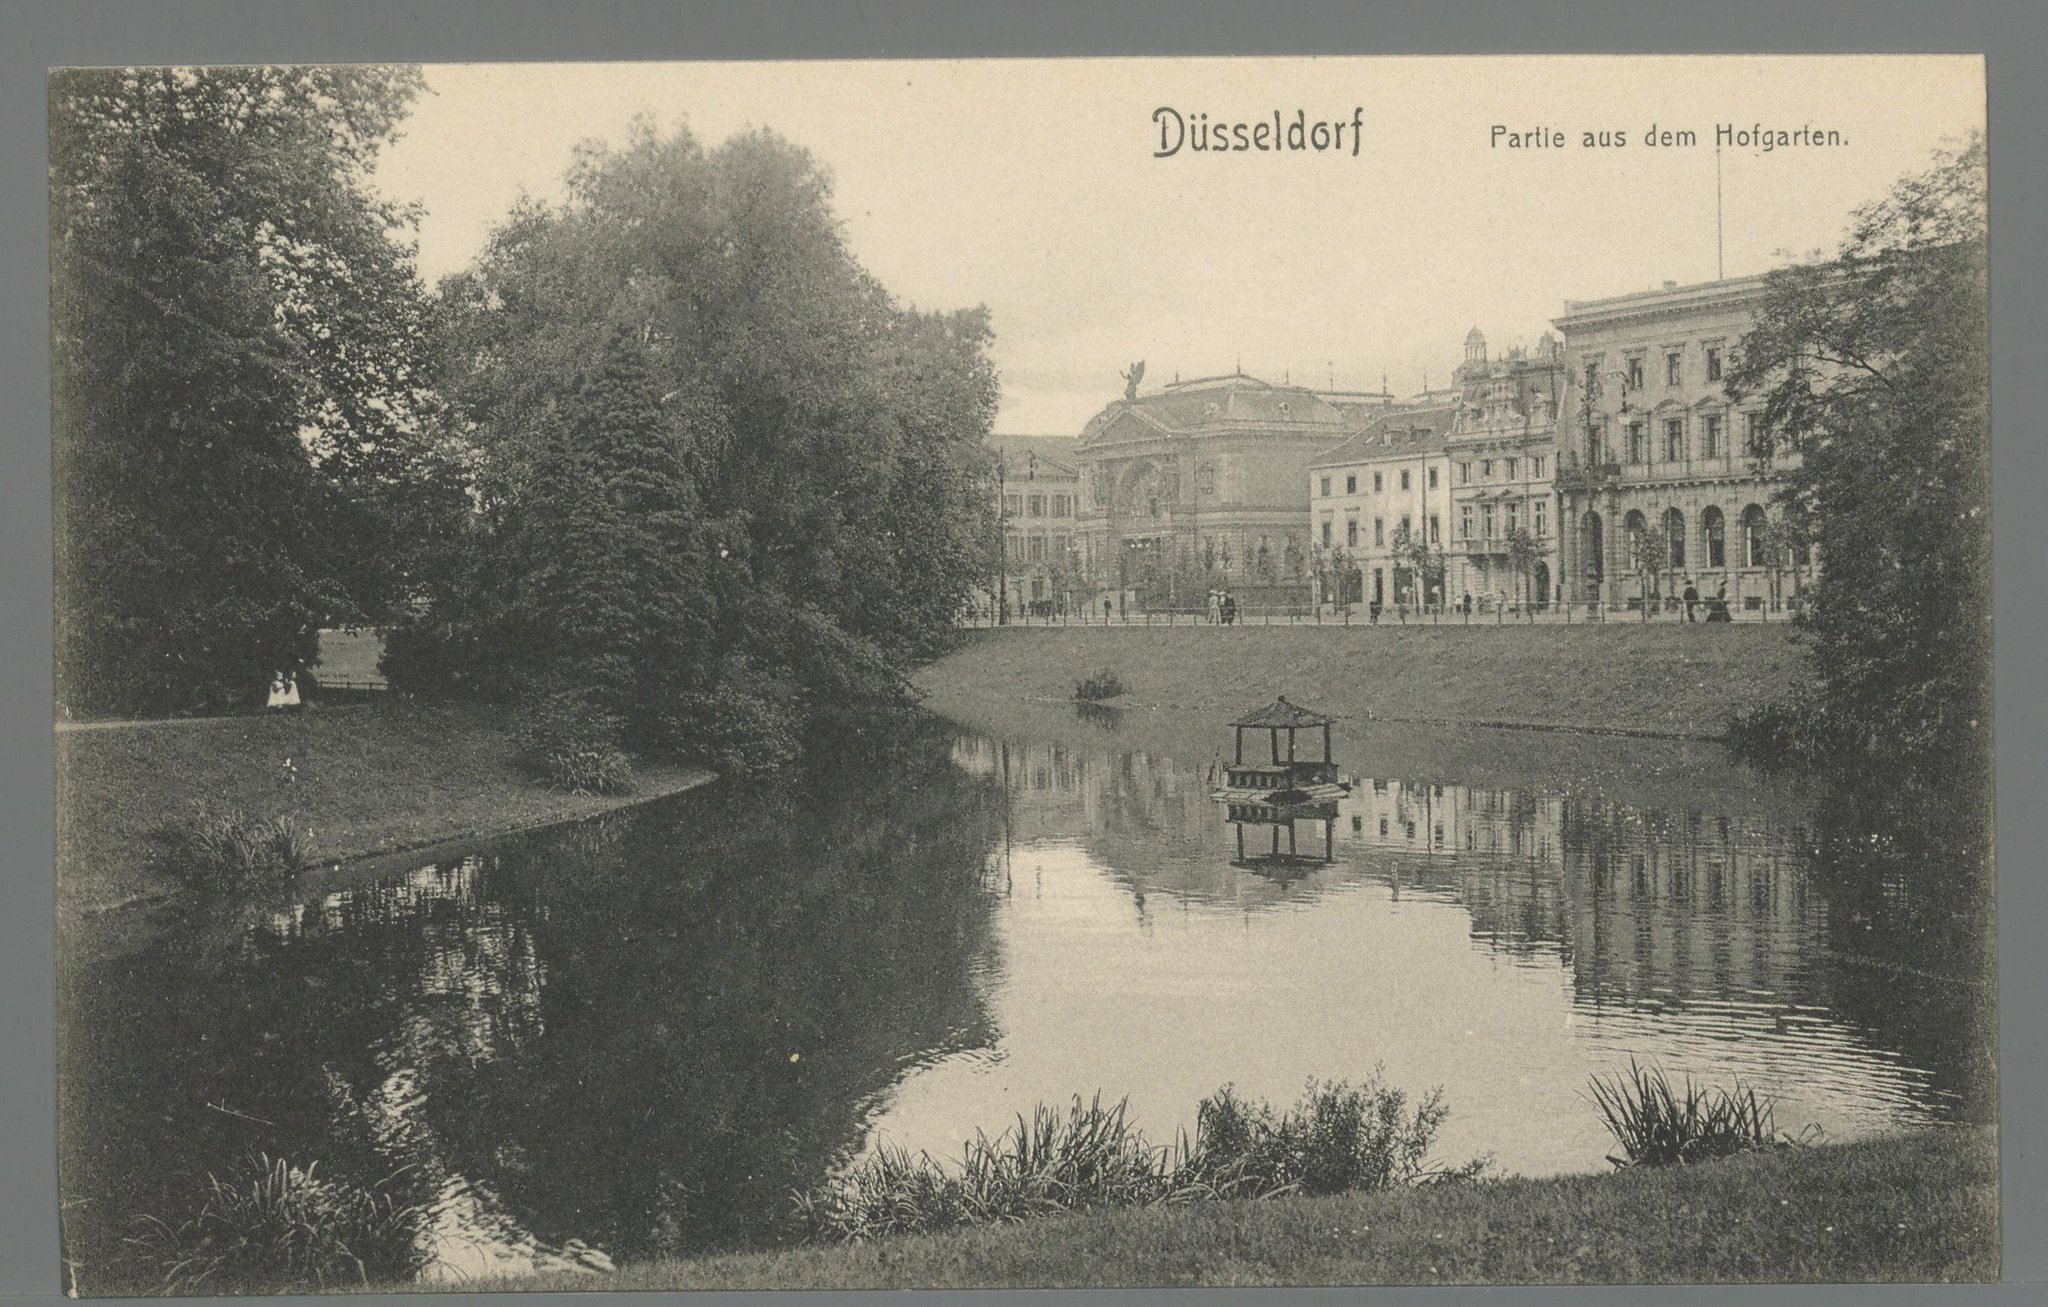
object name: ansichtkaart, prentbriefkaart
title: Düsseldorf. Partie aus dem Hofgarten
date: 1905-1930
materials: cardboard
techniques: photograph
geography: dusseldorf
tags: park, pond